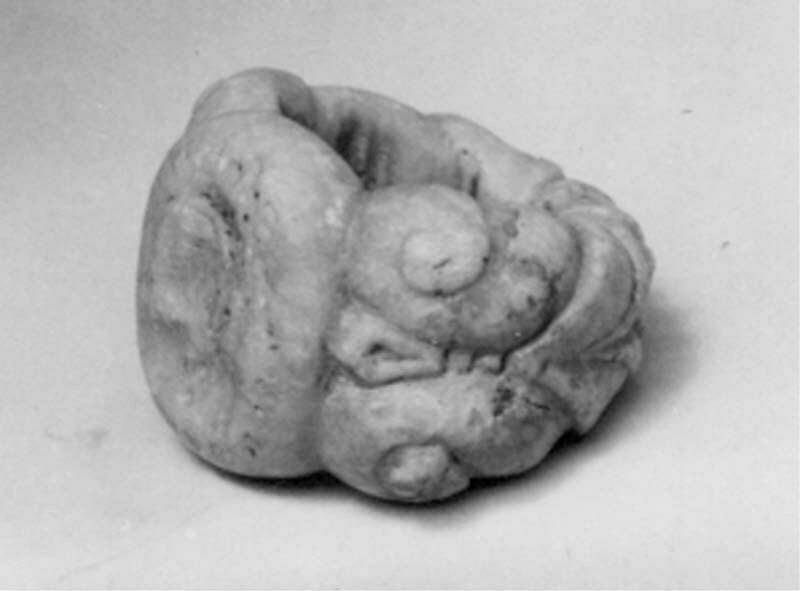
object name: ring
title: Ring seal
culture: sasanian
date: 201-700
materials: alabaster, marble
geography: iran or mesopotamia